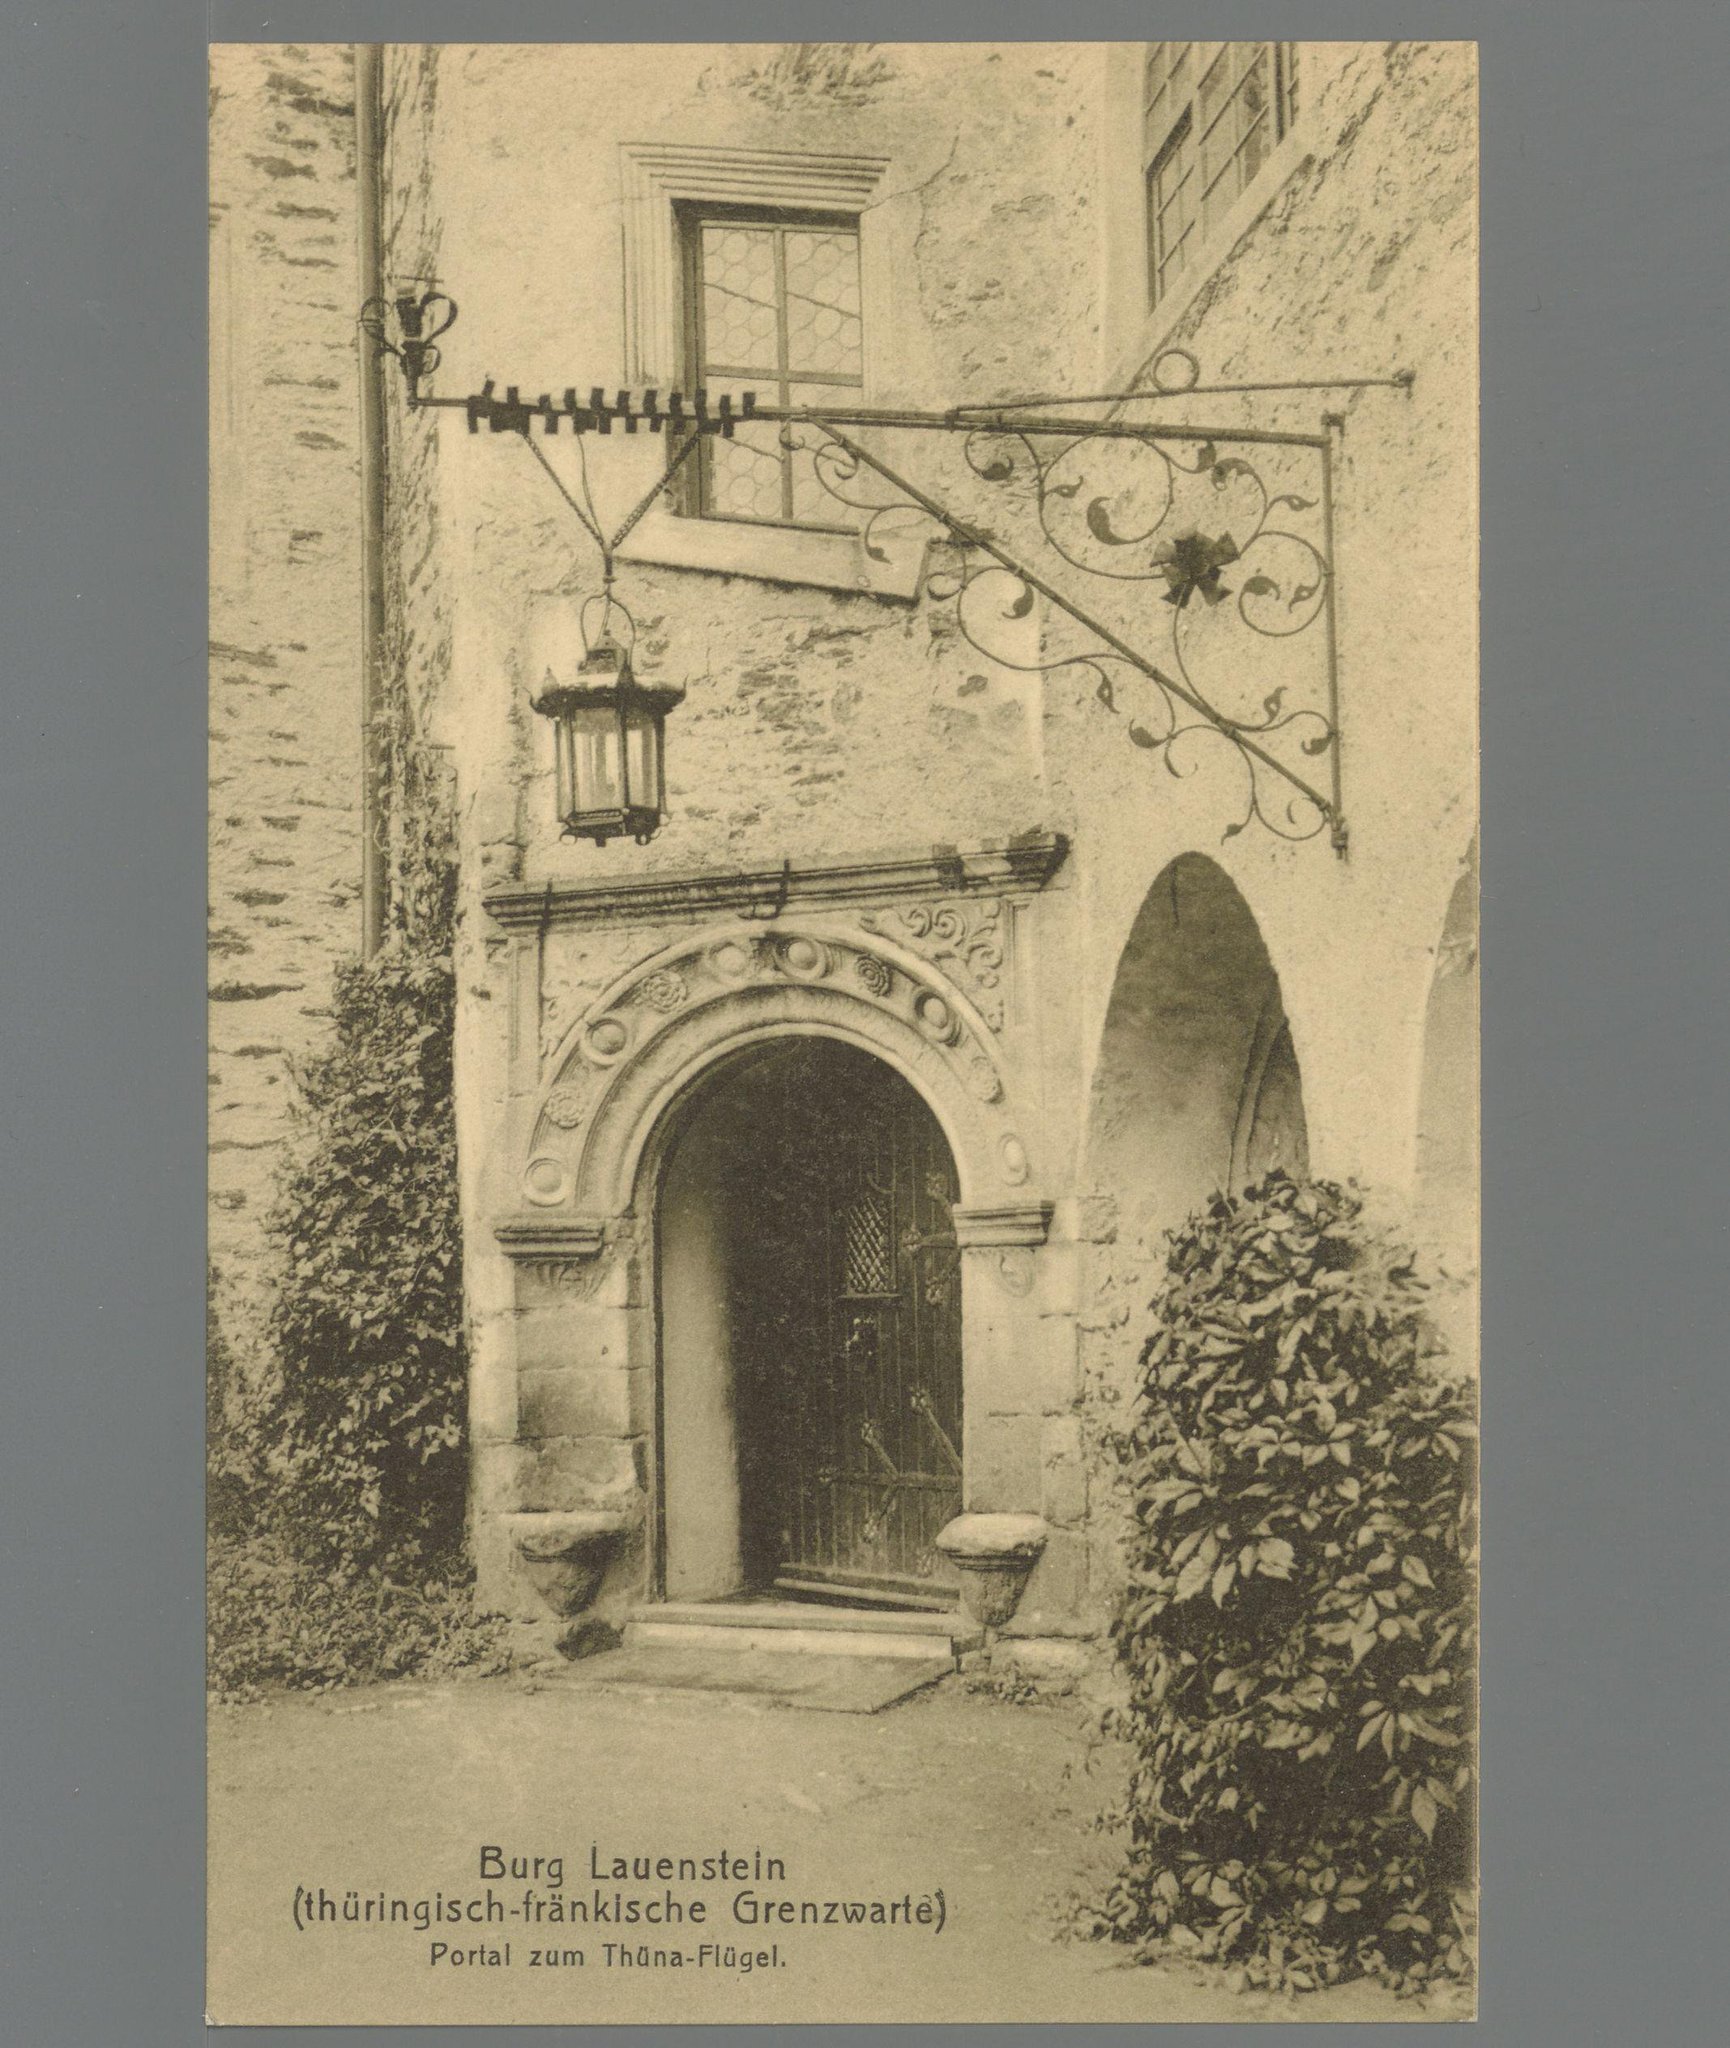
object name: photomechanical print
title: Burg Lauenstein (thüringisch-fränkische Grenzwarte). Portal zum Thüna-Flügel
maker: Anonymous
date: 1905-1930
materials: cardboard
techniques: photograph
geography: ludwigsstadt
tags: castle, gate, entrance